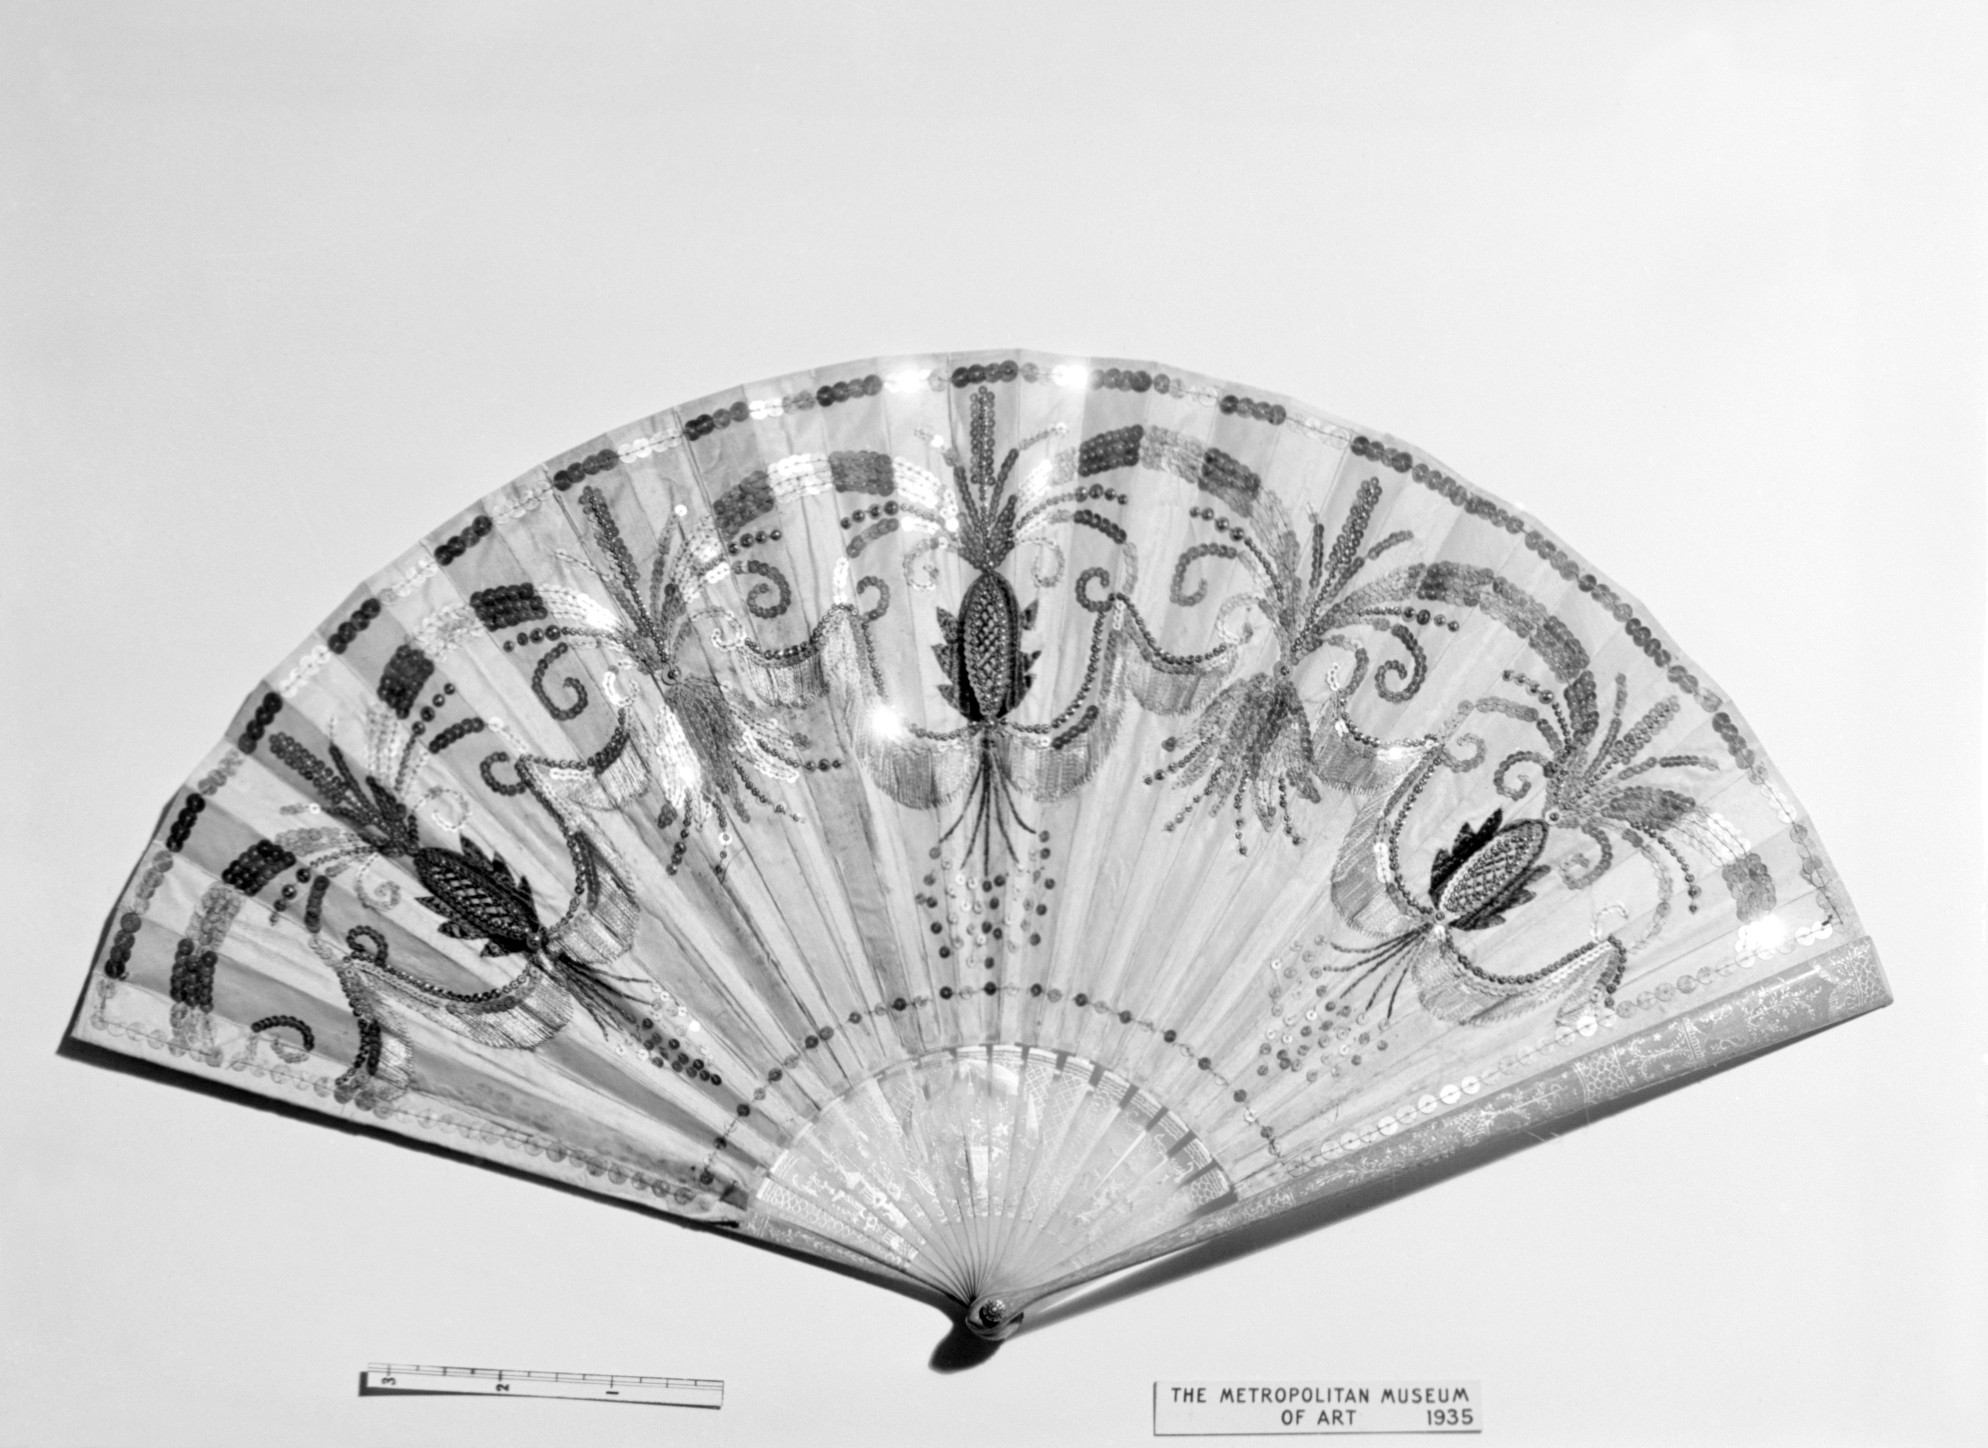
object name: fan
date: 1801-1850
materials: gilt, horn, paint, silk, thread, wood